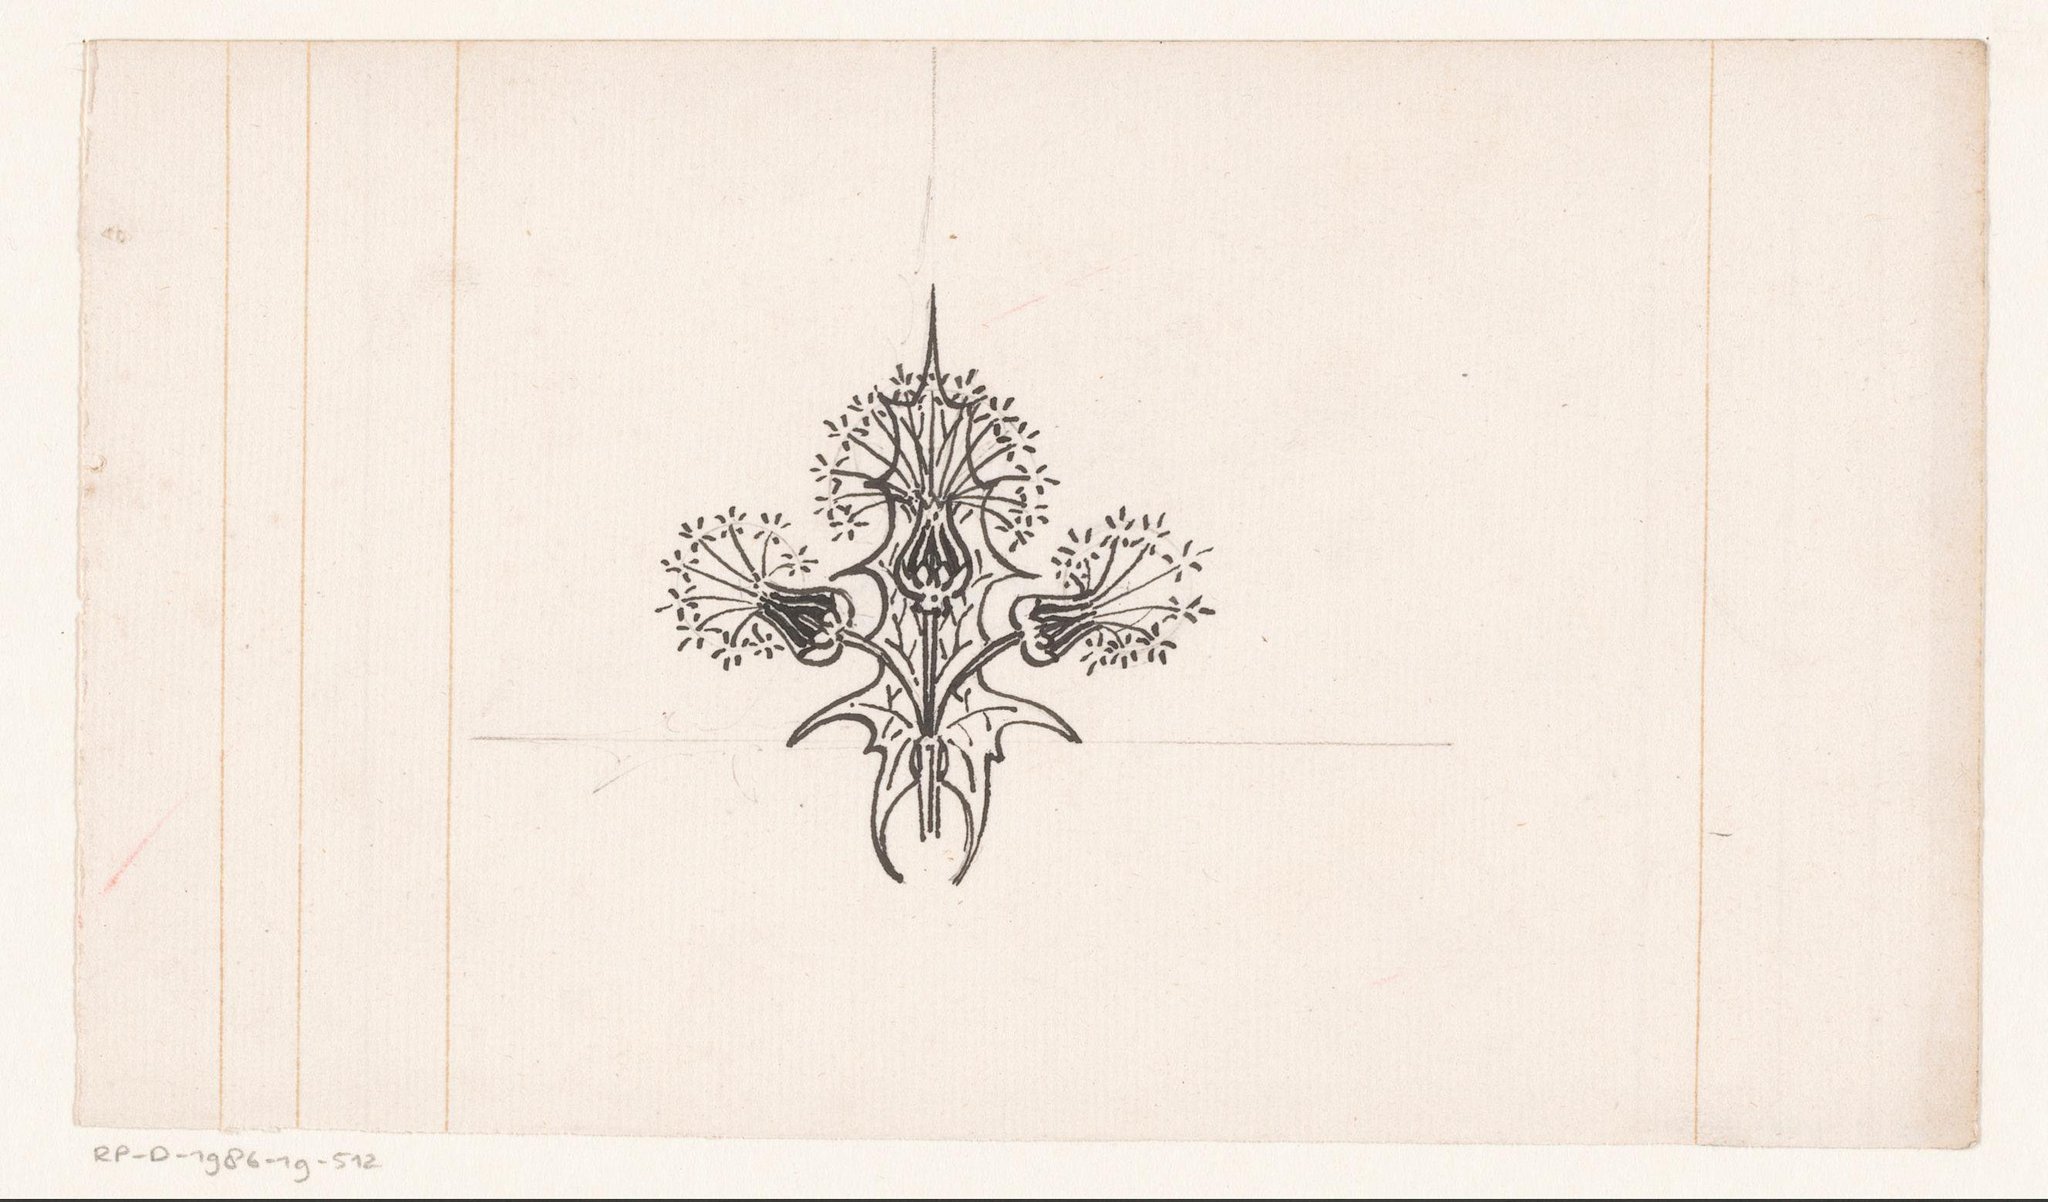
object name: drawing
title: Vignet met distel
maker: reinier willem petrus de vries (1874-1953)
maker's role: draughtsman, print maker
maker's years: 1874-1953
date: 1884-1952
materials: ink, paper, pencil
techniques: pen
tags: plants and herbs: thistle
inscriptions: collector's mark: ‘R:MVS.’